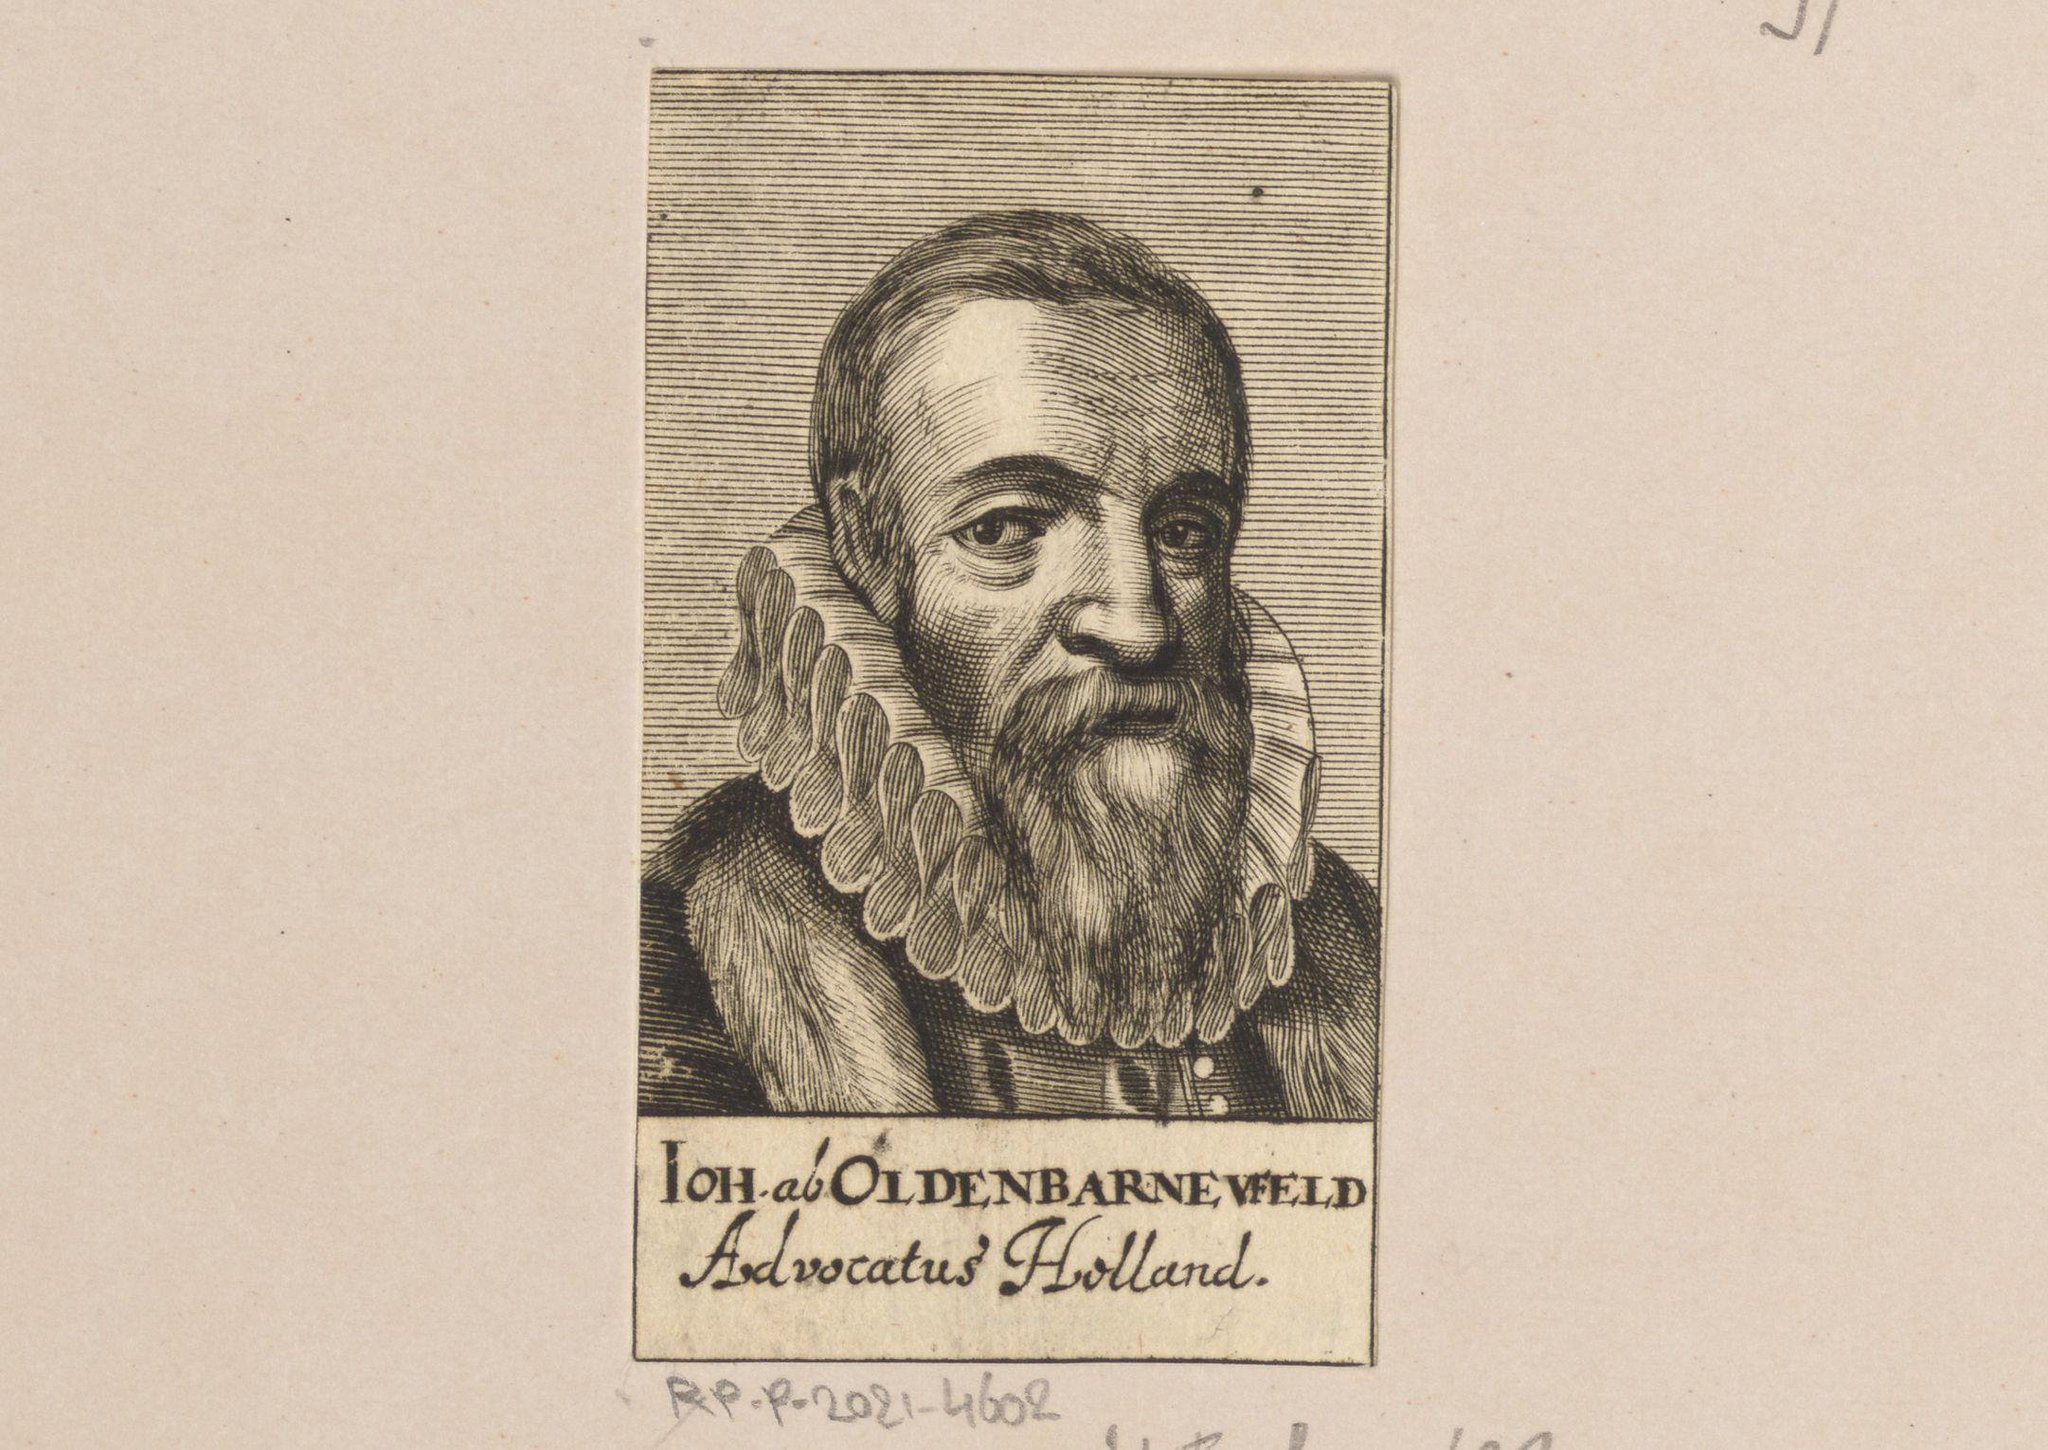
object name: book illustration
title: Portret van Johan van Oldenbarnevelt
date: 1688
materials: paper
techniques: engraving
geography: nuremberg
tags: the hague, johan van oldenbarnevelt, historical persons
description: Prent uit: Freher, Paul. Theatrum virorum eruditione clarorum. Neurenberg: Johann Hoffmann, 1688.